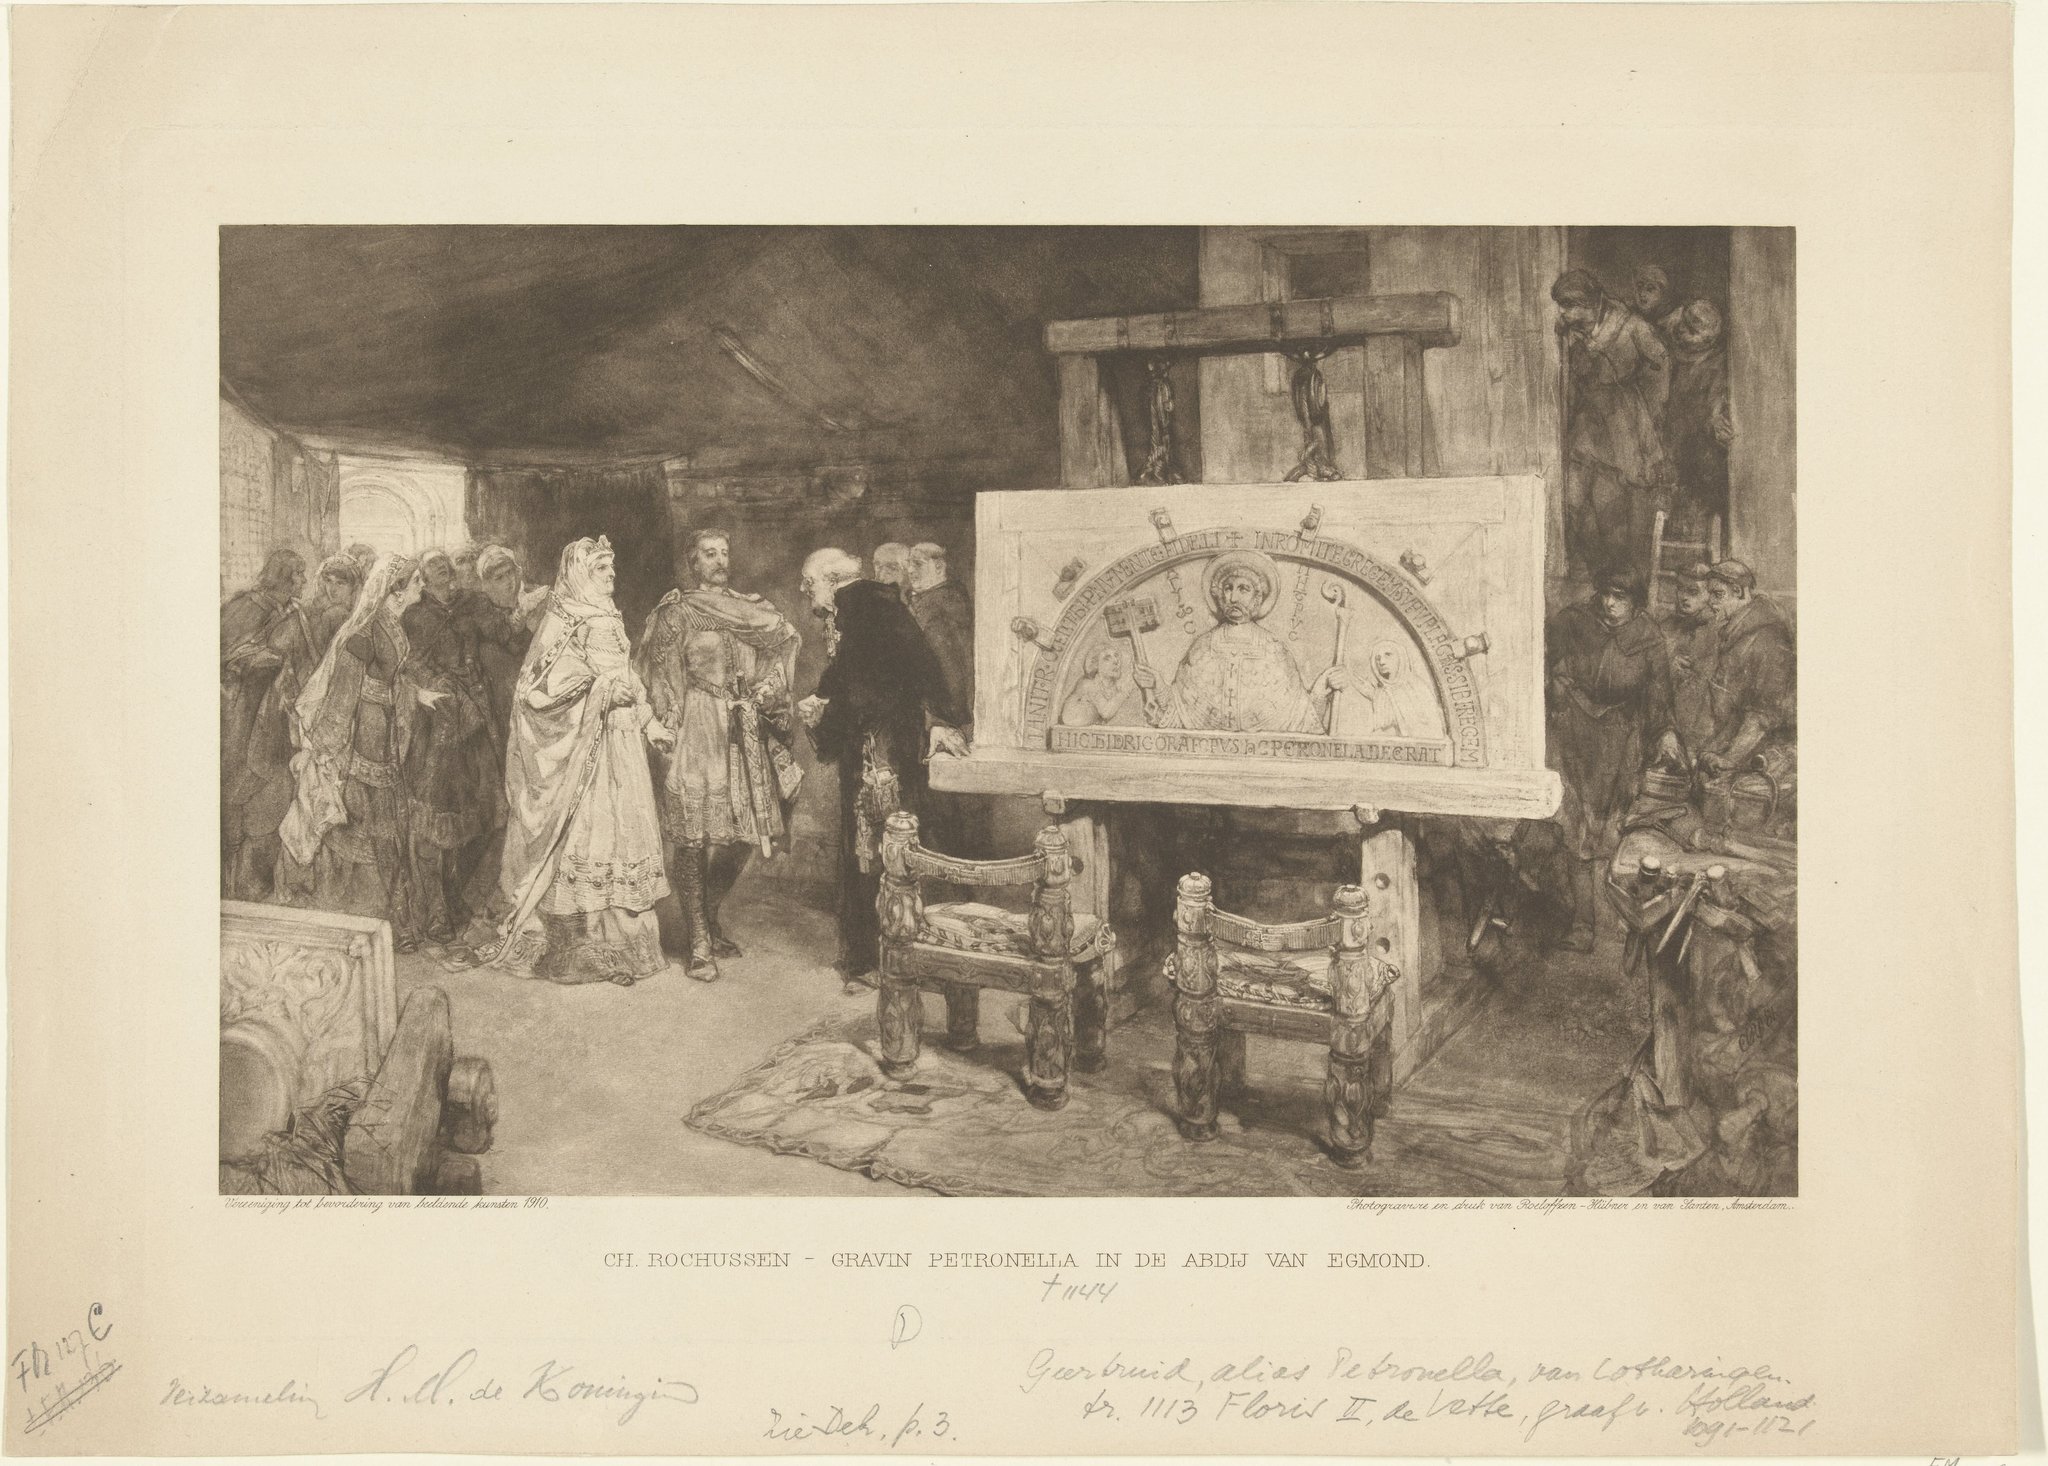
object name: print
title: De beeldhouwer toont het timpaan van Egmond aan gravin Petronella, ca. 1120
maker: charles rochussen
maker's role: draughtsman, painter, print maker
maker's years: 1814-1894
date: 1910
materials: paper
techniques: photoaquatint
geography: amsterdam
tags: piece of sculpture, reproduction of a piece of sculpture, art (+ relief ~ sculpture), sculptor in non-work situation, patron (or client) visiting the artist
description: De beeldhouwer van het timpaan voor de abdij van Egmond: boogtrommel met Petrus, graaf Dirk VI van Holland en zijn moeder gravin Petronella, ontvangt gravin Petronella met zoon Dirk VI en haar gevolg in zijn atelier in de abdij van Egmond. Het net voltooide reliëf staat op een ezel, met twee stoelen ervoor. Rechts kijken monniken toe Petronella (oorspronkelijk Geertruida) van Saksen was de echtgenote van Floris II, graaf van Holland. De steen is vervaardigd ca. 1120, de voorstelling moet zich dan ook in die periode afspelen.